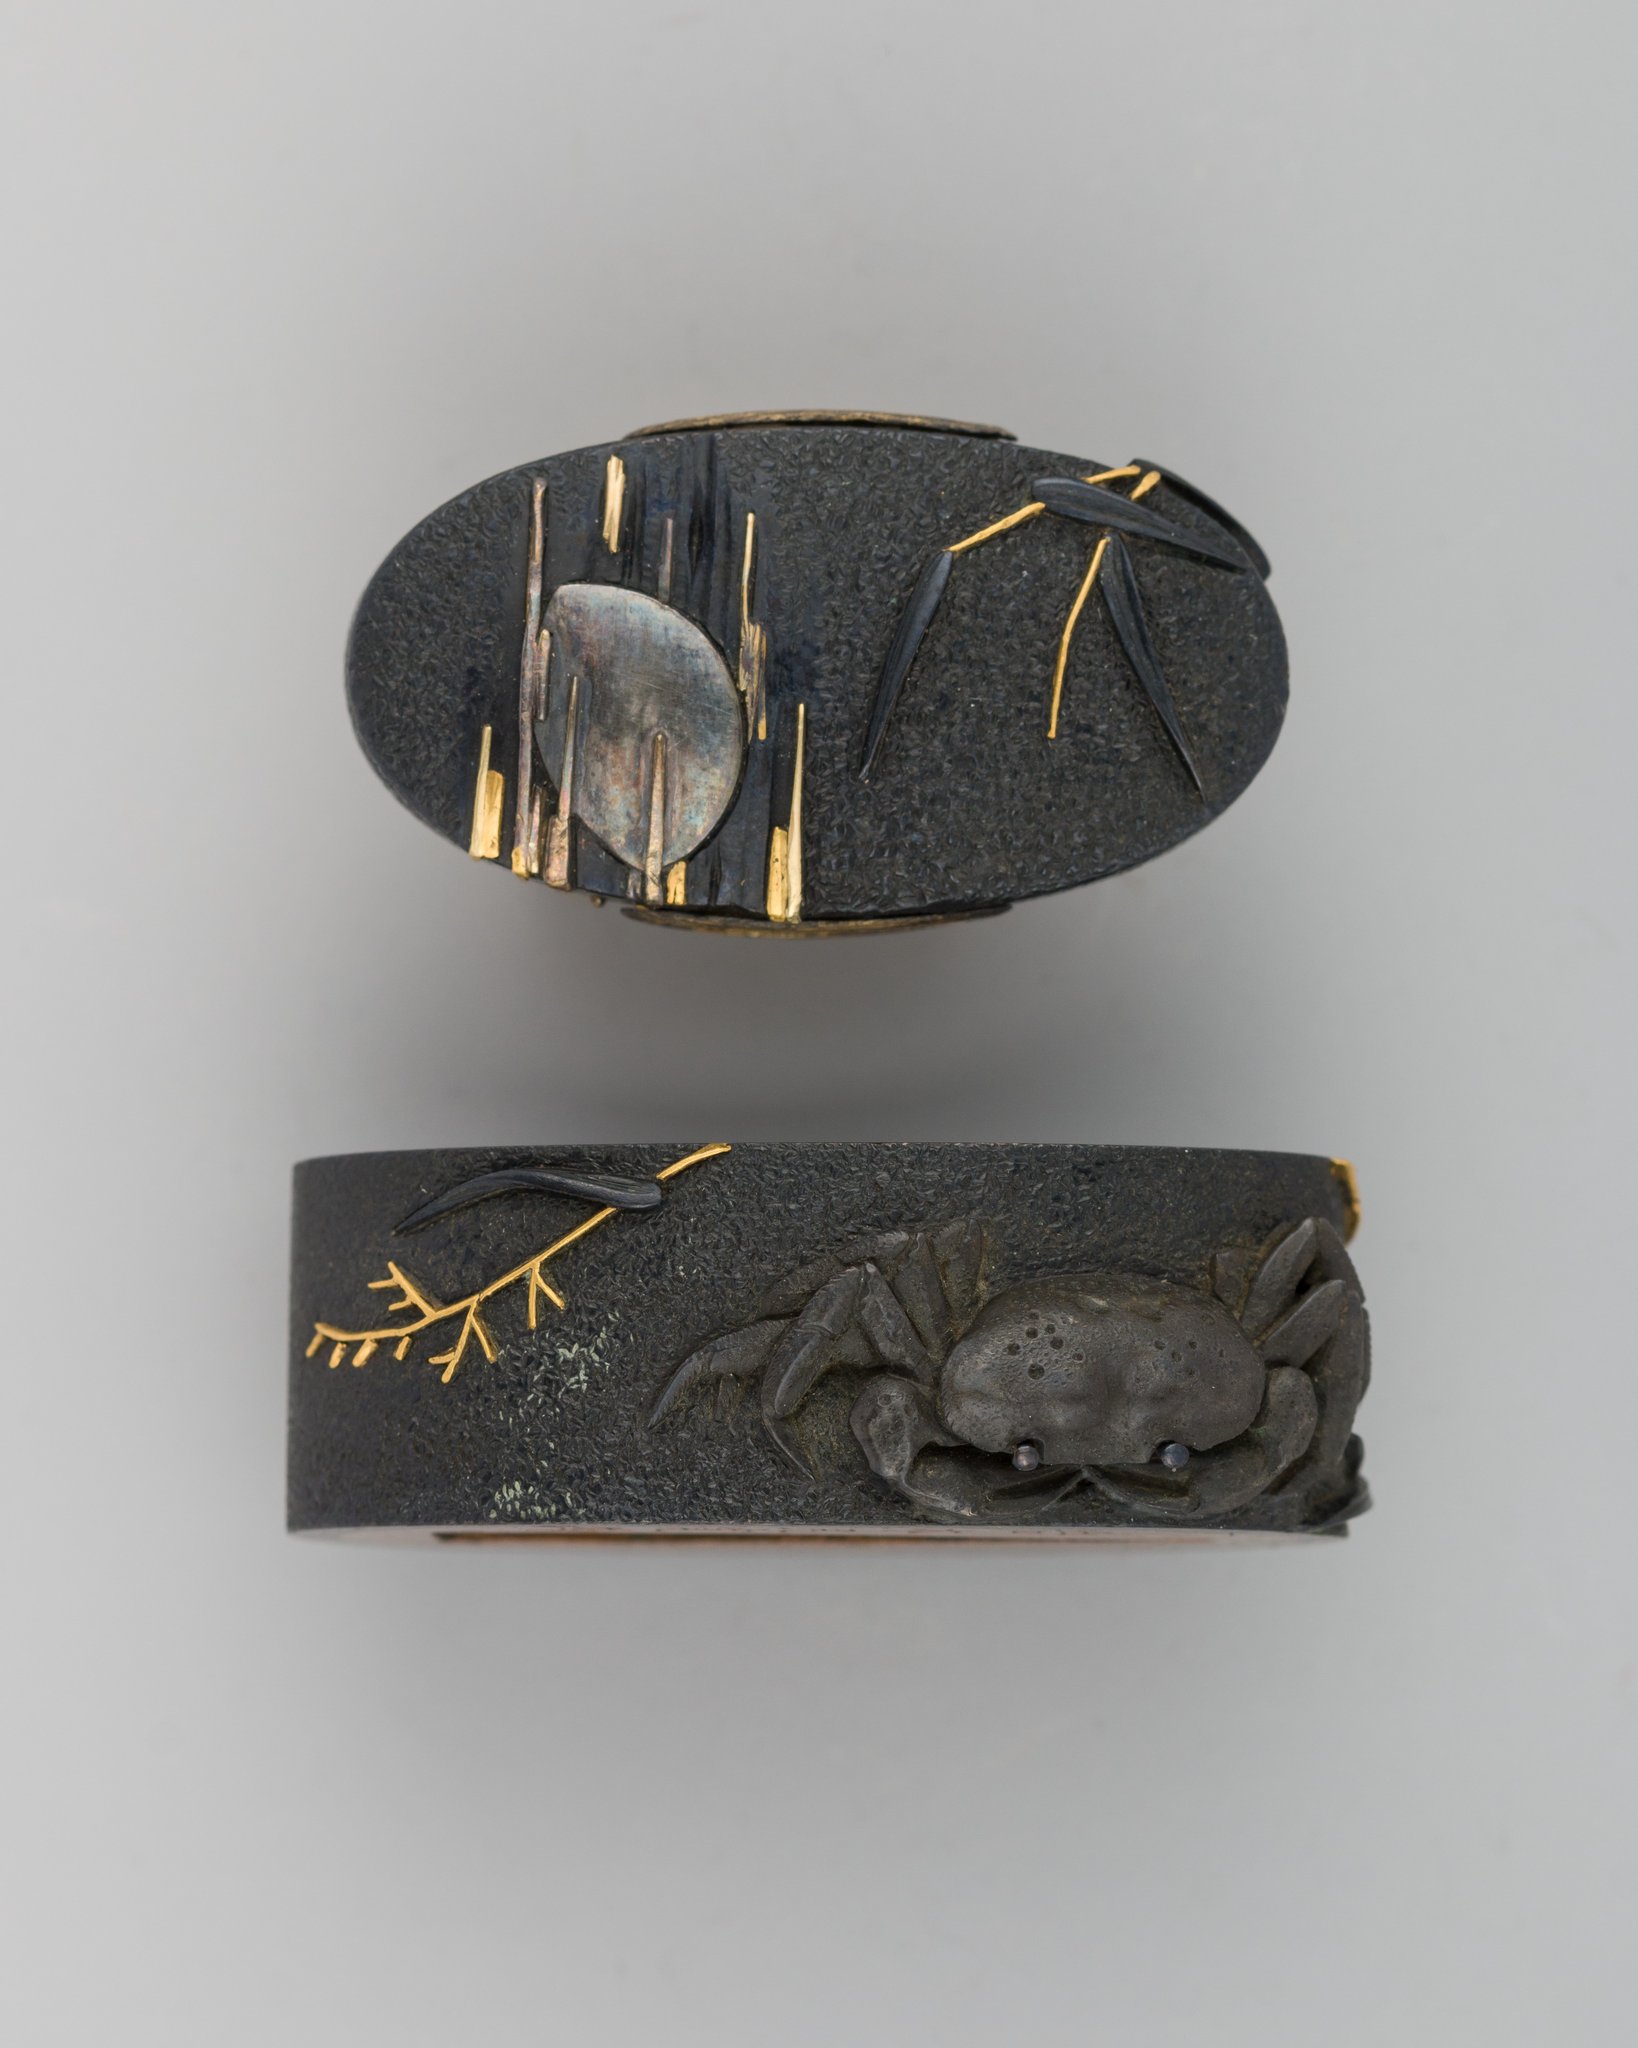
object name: sword hilt collar and pommel fuchigashira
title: Sword-Hilt Collar and Pommel (Fuchigashira)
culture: japanese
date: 1743-1801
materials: gold alloy, silver alloy, gold, silver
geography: japan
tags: crabs